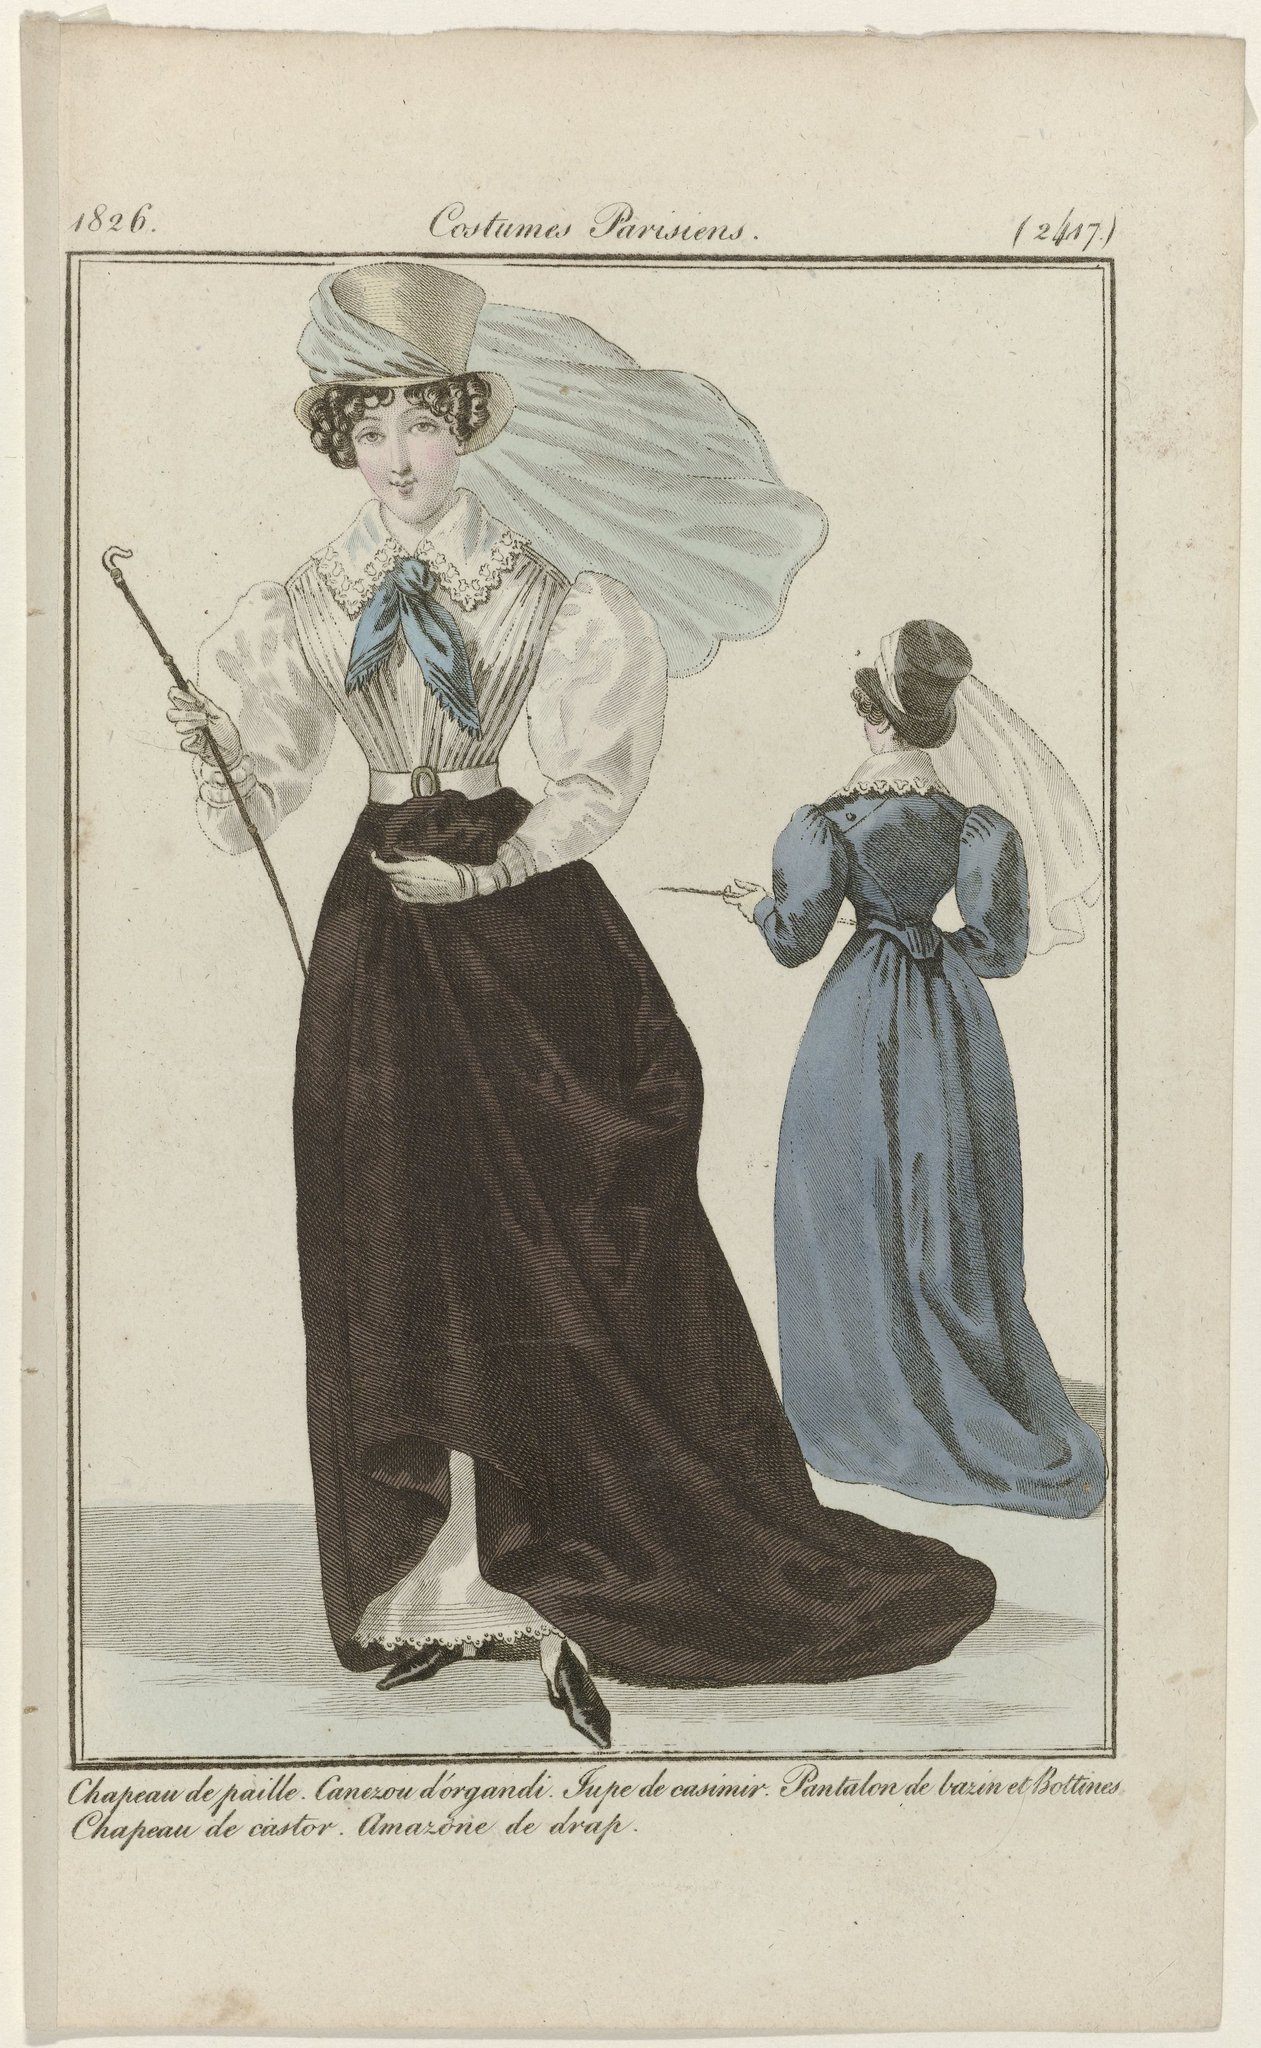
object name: fashion print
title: Journal des Dames et des Modes, Costumes Parisiens, 25 juin 1826, (2417): Chapeau de paill (...)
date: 1826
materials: paper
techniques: engraving, hand coloring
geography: paris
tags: gloves, mittens (long gloves) (+ women's clothes), walking-stick, staff, cane (+ women's clothes), veil (+ women's clothes), clothing for the upper part of the body: blouse (+ women's clothes), trousers, breeches (+ women's clothes), fashion plates, shoes, sandals (+ women's clothes), skirt (+ women's clothes), neck-gear ~ clothing (+ women's clothes), ensembles of pieces of clothing (riding costume) (+ women's clothes)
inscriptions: title: ‘Costumes Parisiens.’, caption: ‘Chapeau de paille. Canezou d'organdi. Jupe de casimir. Pantalon de bazin et Bottines. Chapeau de castor. Amazone de drap.’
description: Vrouw in een 'canezou' van organdie met schapenboutmouwen op een rok van 'casimir' met sleep. Onderrok en lange broek van 'bazin'. Op het hoofd een hoge strohoed met sluier. Verdere accessoires: sjaal om de hals geknoopt, ceintuur met gesp, handschoenen, zweep, laarzen. Op de achtergrond een vrouw, op de rug gezien, in een amazonekostuum (rijkostuum) van laken. Op het hoofd een hoge hoed van 'castor' met sluier. De prent maakt deel uit van het modetijdschrift Journal des Dames et des Modes, uitgegeven door Pierre de la Mésangère, Parijs, 1797-1839.